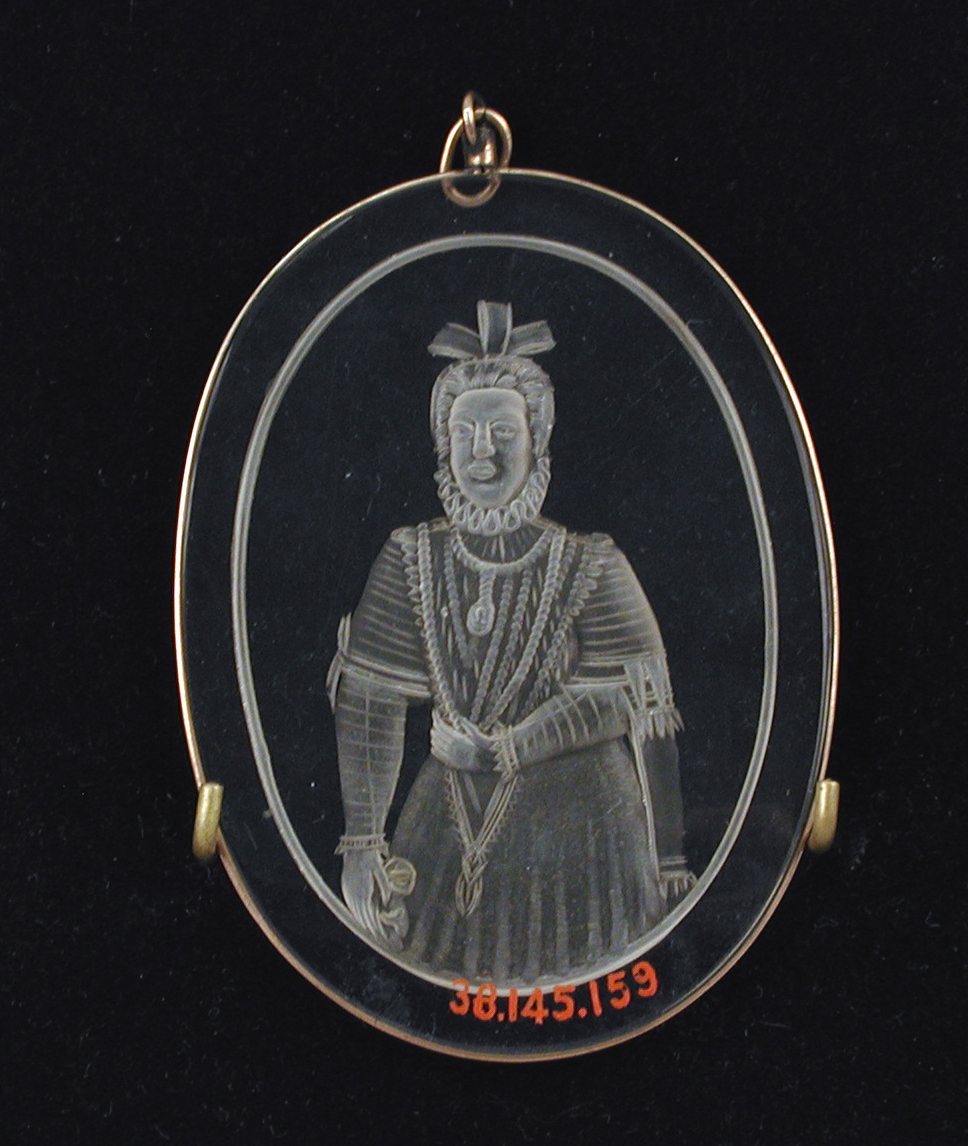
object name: medallion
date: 1801-1900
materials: glass, gold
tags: men,portraits